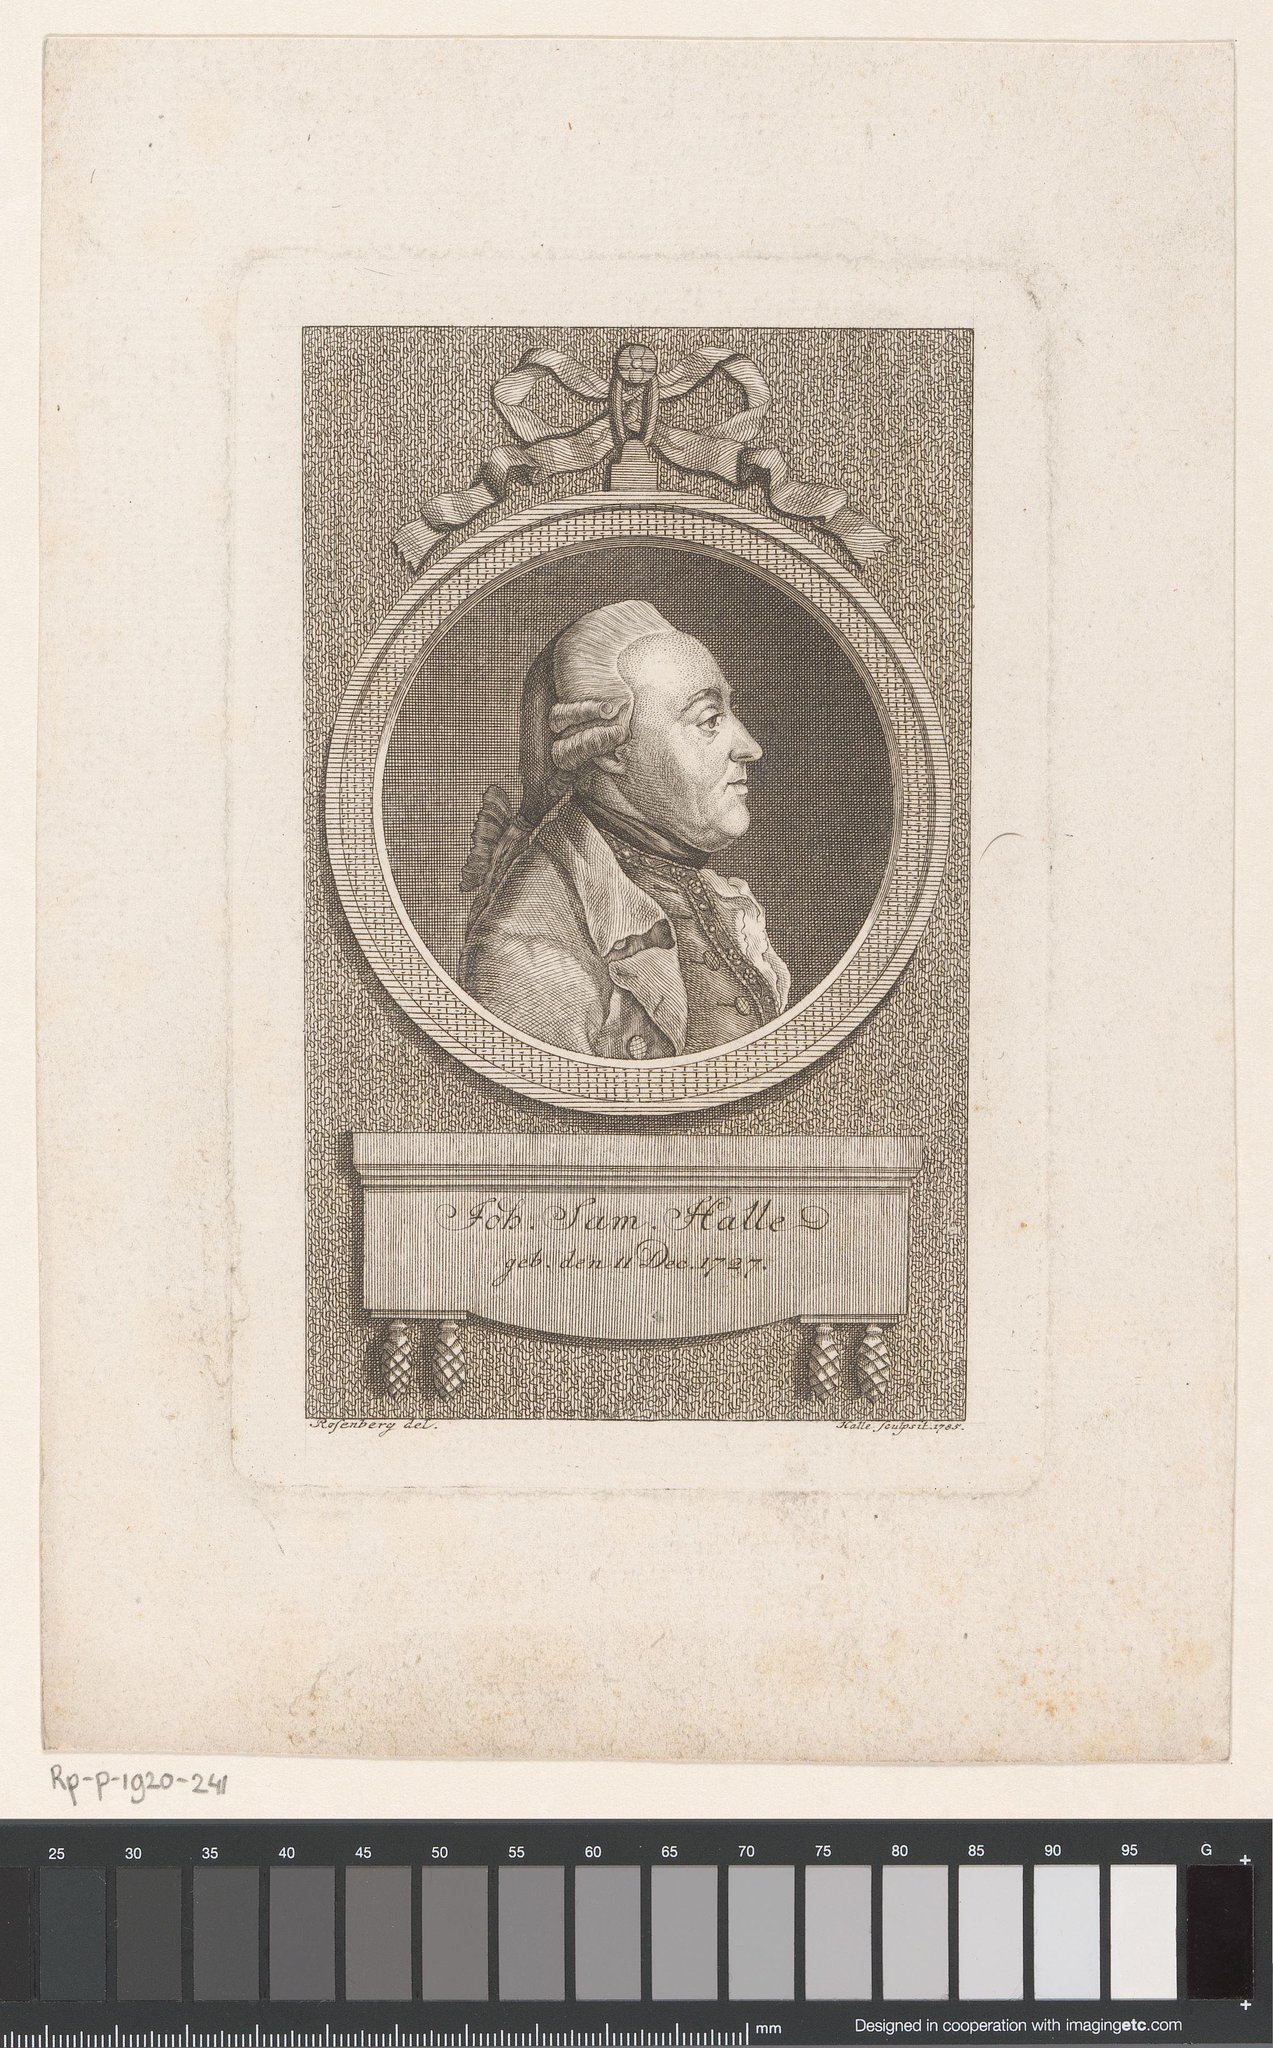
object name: print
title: Portret van Johann Samuel Halle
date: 1785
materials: paper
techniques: engraving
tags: berlin, ornament ~ medallion, historical persons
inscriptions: collector's mark: Lugt 2228